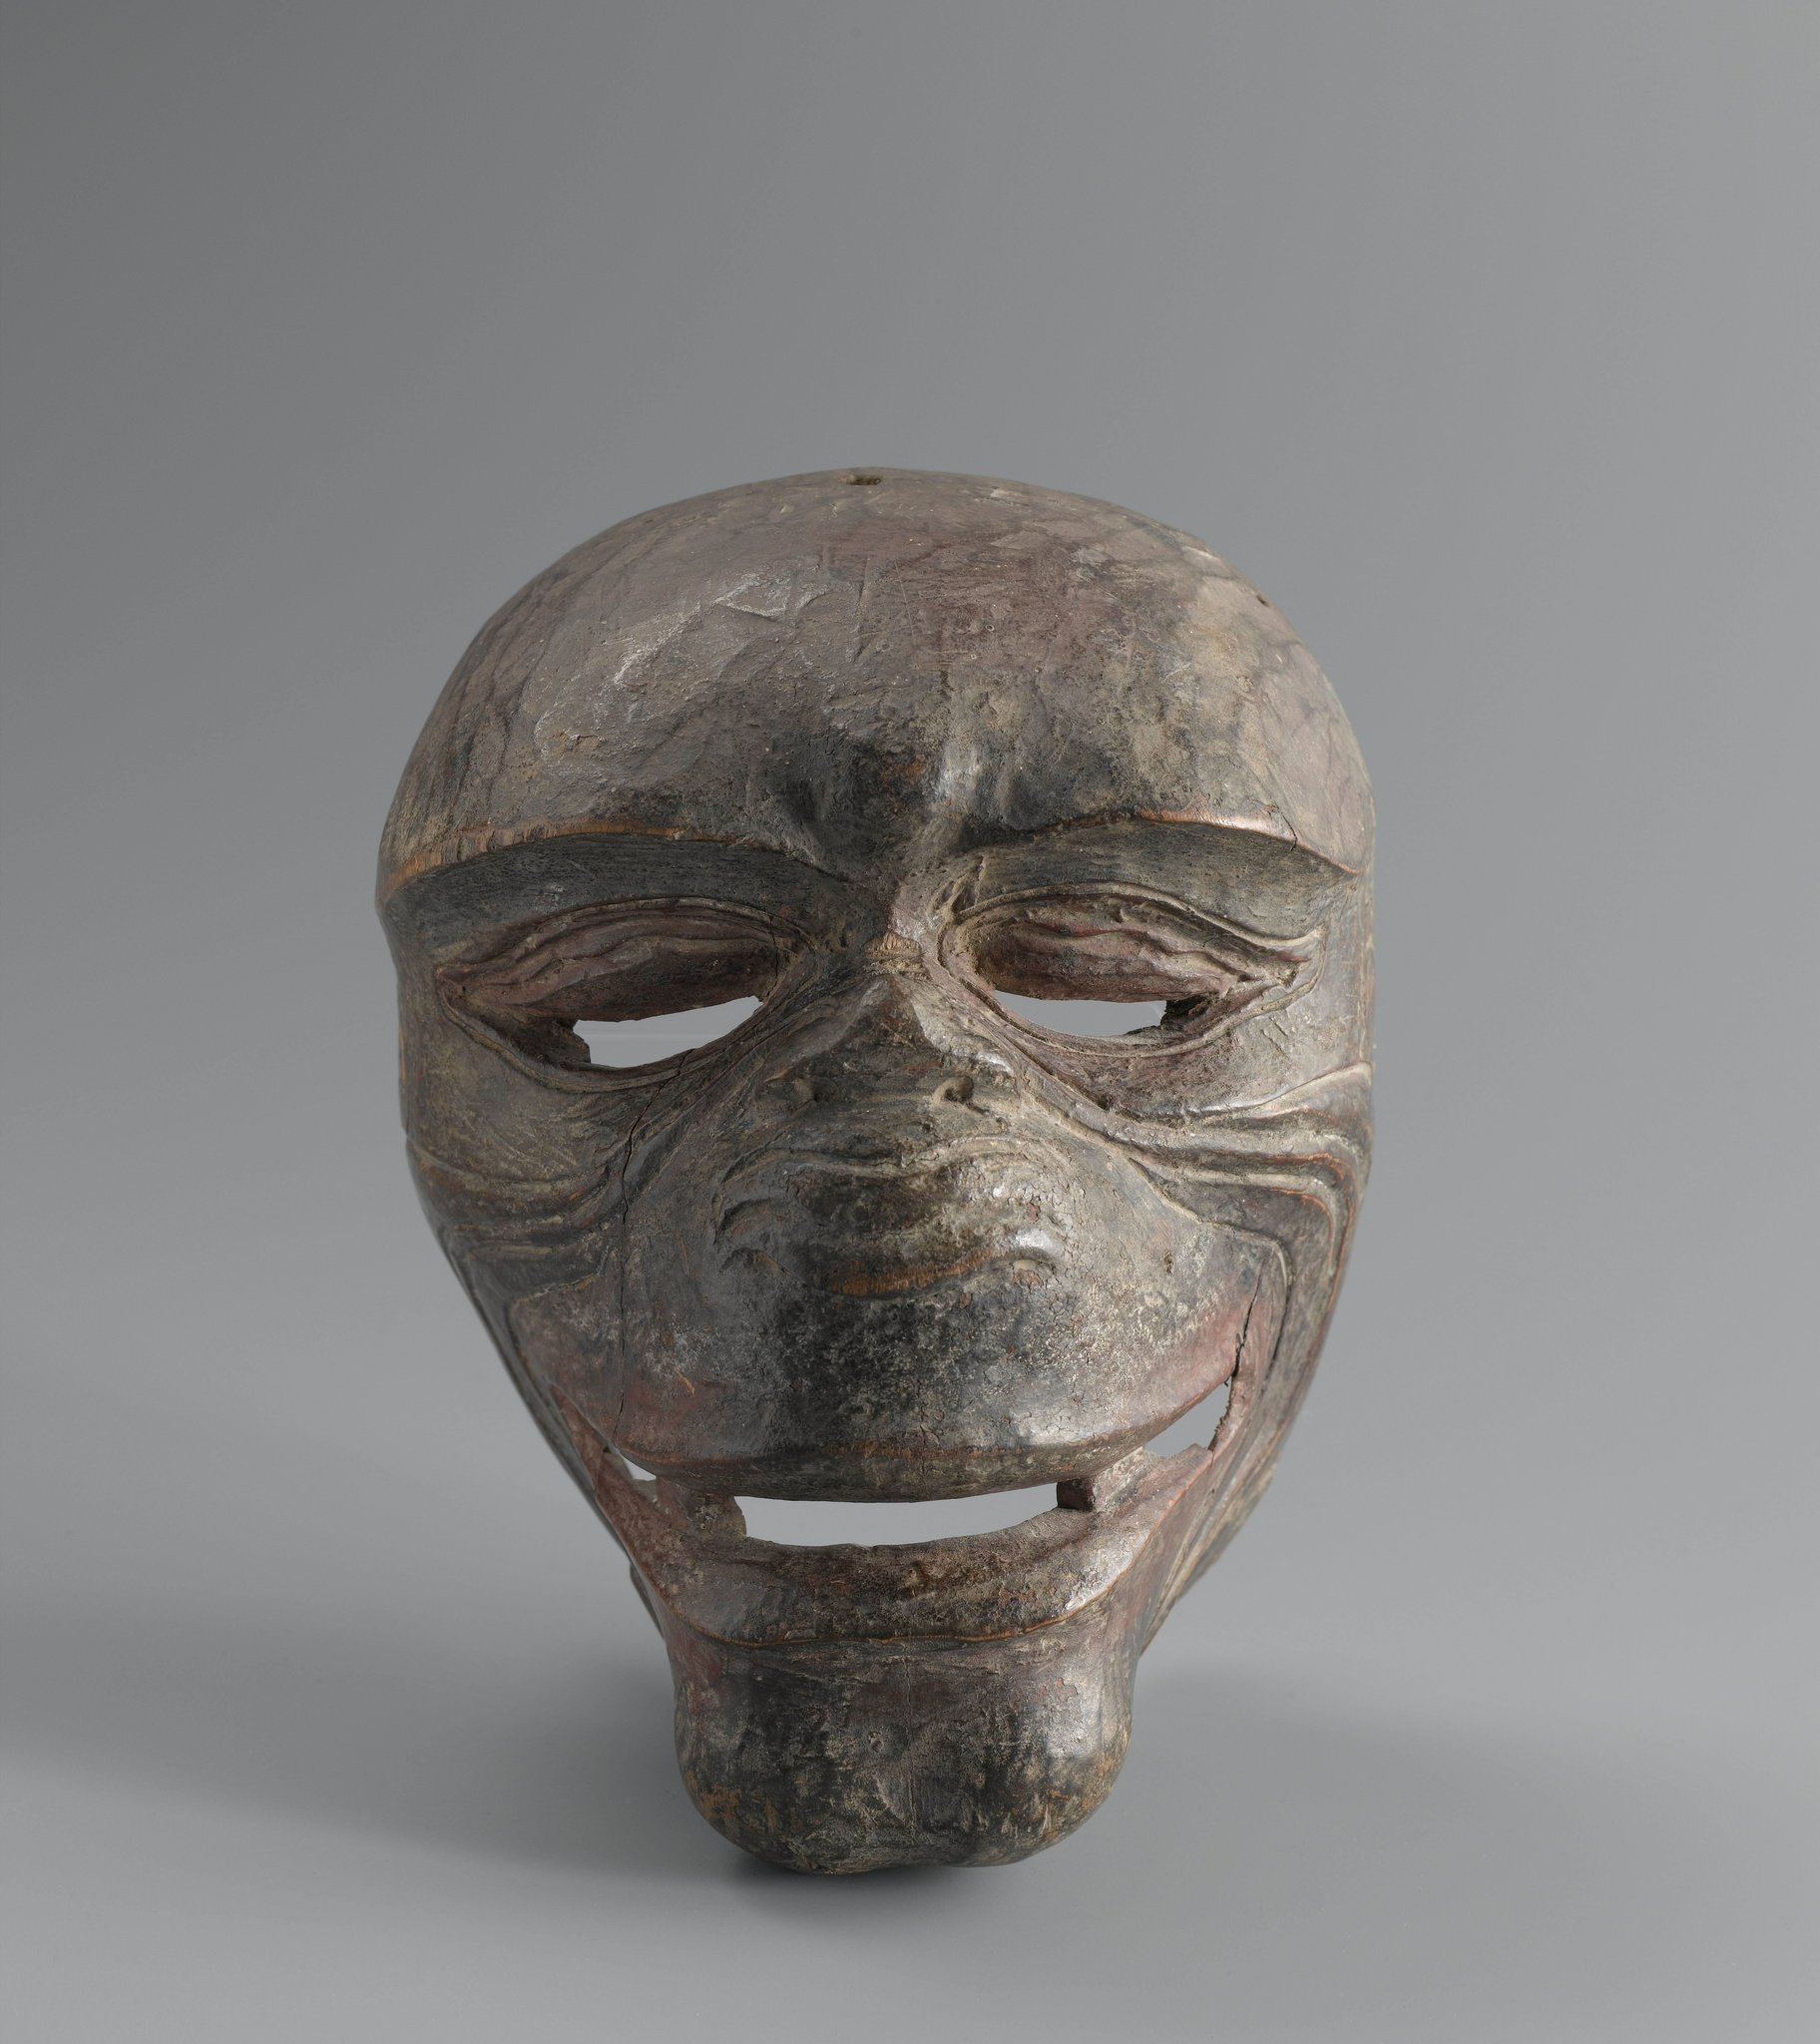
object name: mask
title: Masker van de ponokawan Semar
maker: Anonymous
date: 1800-1900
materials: dye, wood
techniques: polychromy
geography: java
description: Gepolychromeerd houten masker van de ponokawan Semar.